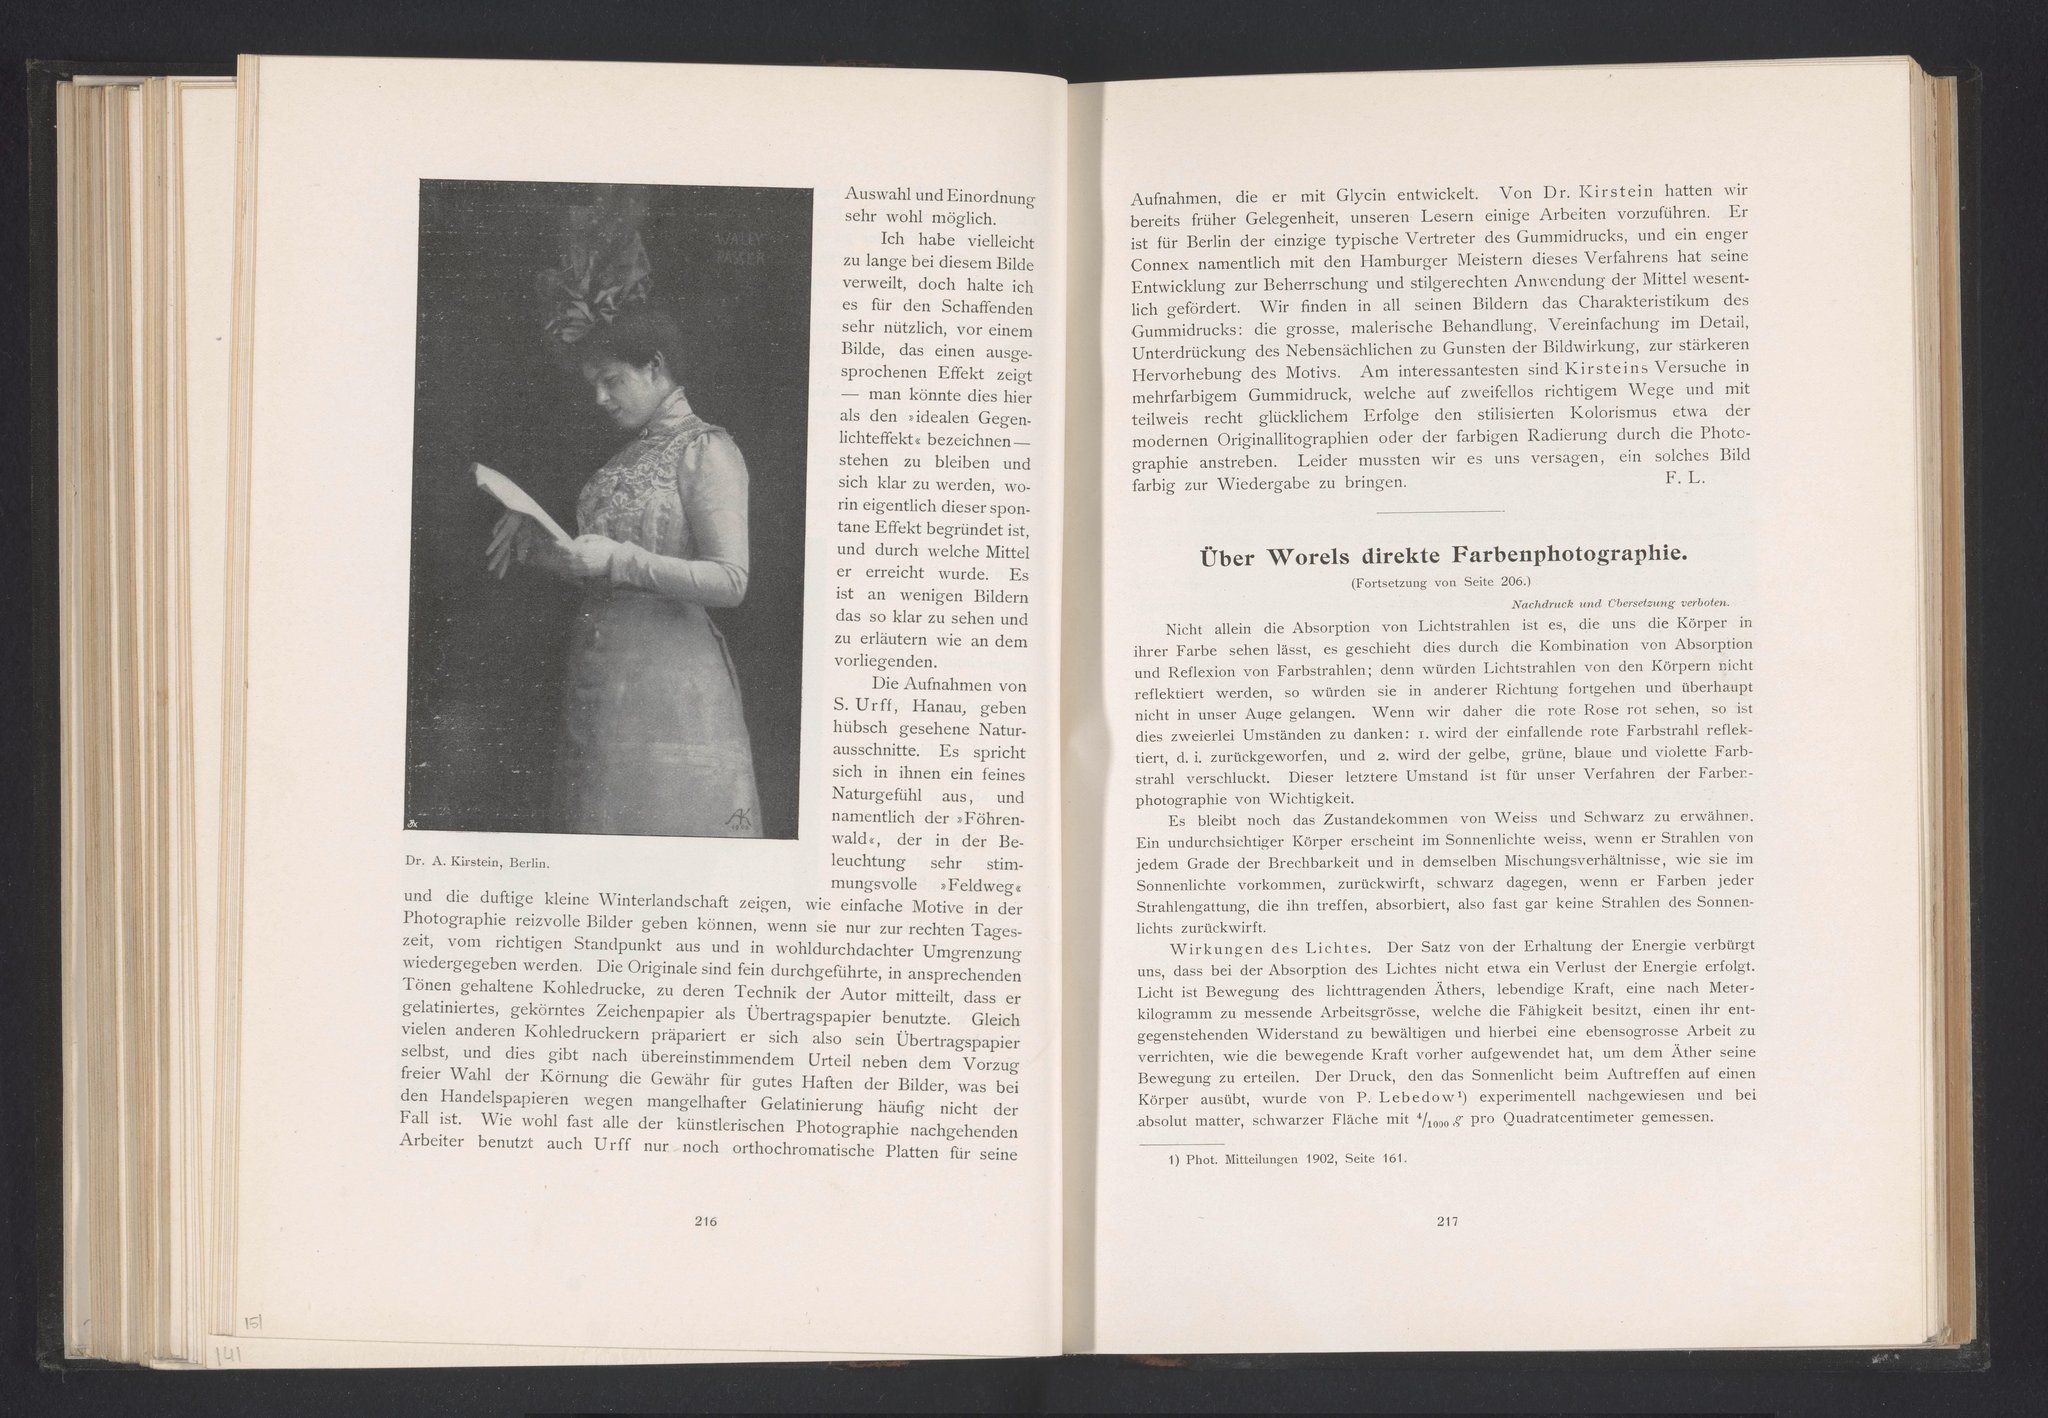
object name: page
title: Portret van een onbekende vrouw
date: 1898-1903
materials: paper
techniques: autotype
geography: berlin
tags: historical persons - bb - woman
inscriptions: monogram: ‘BX’